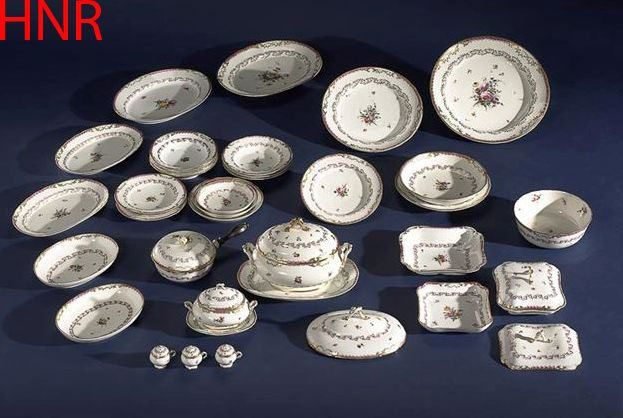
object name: plate dish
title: Bord, diep model, behorend bij een servies met geslingerd lintmotief met bladertakken, bloemboeketten en gestrooide bloemtakken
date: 1780-1820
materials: porcelain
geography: amsterdam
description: Bord, diep model, behorend bij een servies van porselein met geslingerd lintmotief in paars en goud met groene bladertakken, bloemboeketten en gestrooide bloemtakken. Randen lichtgegolfd met decoratie in goud met paars bladmotief waartussen groen gekruist bladmotief. Gemerkt: M.O.L. en Amstel. Serie van vijftien stuks.